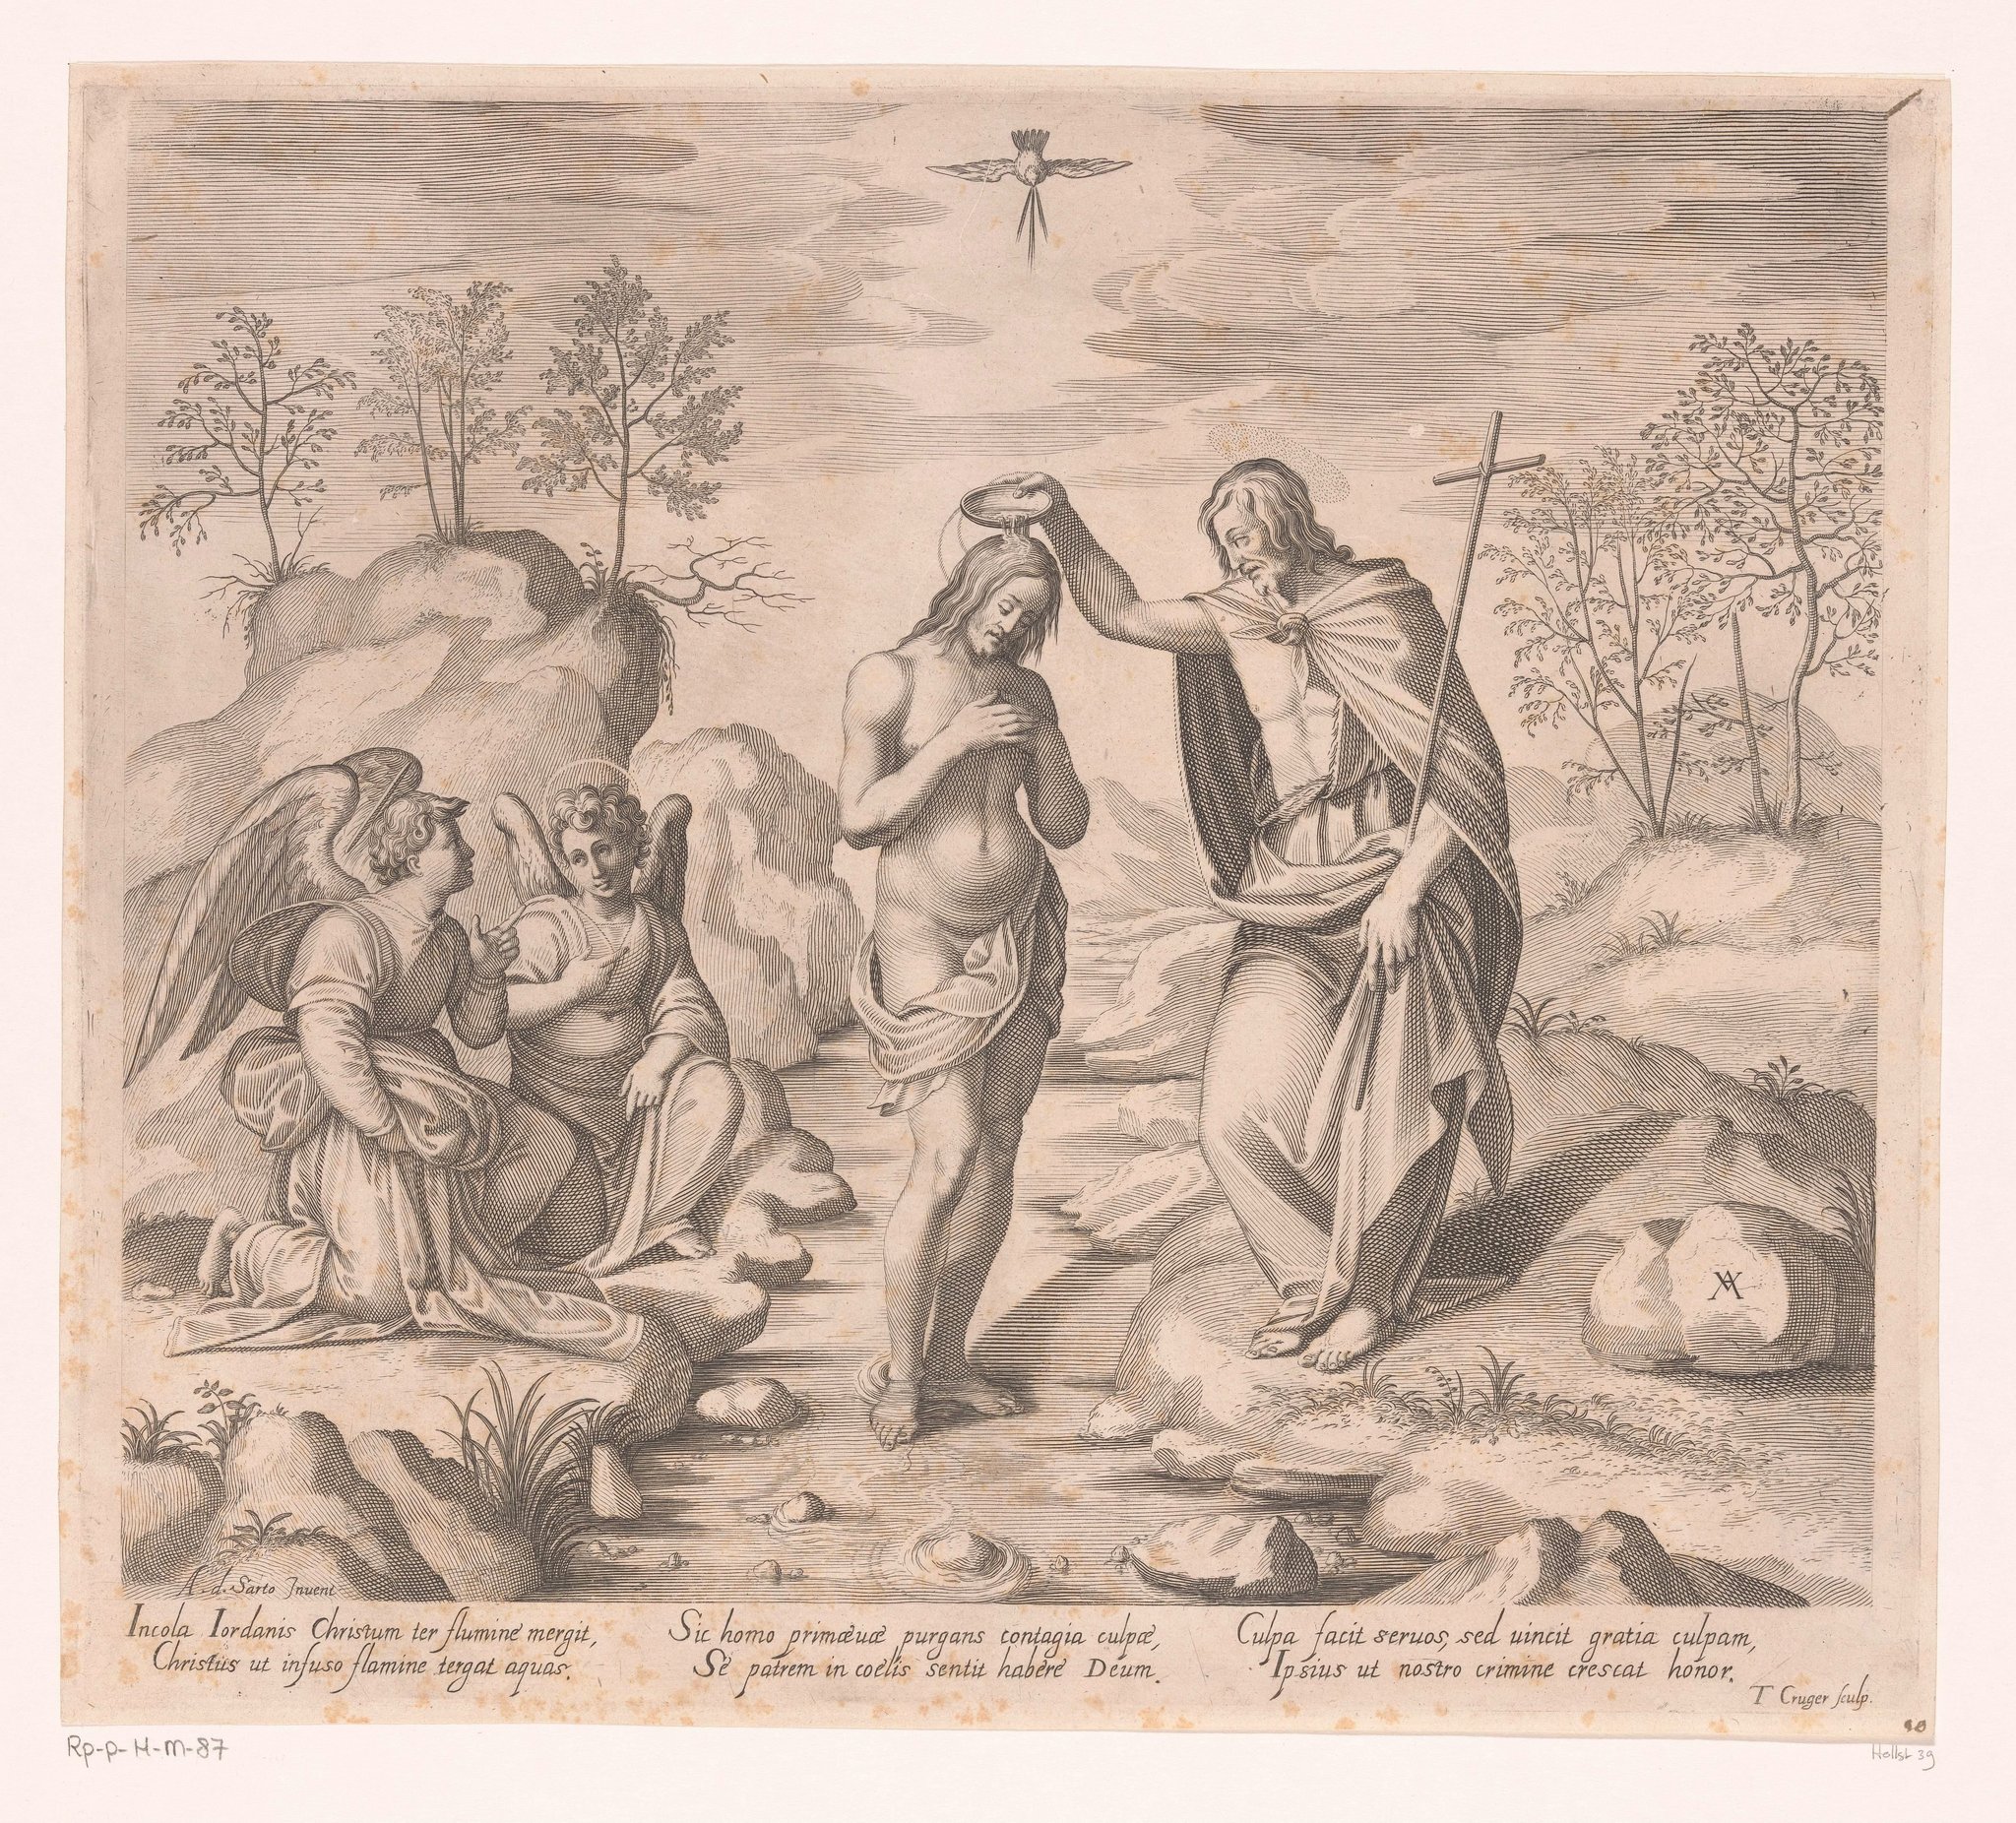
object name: print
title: Doop van Christus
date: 1617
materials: paper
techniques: engraving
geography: florence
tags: baptism of christ in the river jordan: john the baptist pouring out water on christ's head: the holy ghost descends (+ angel(s))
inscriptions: monogram: ‘AV’, collector's mark: Lugt 11, collector's mark: ‘Hinloopen’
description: Onderdeel van een serie van dertien prenten en een titelprent. Origineel onderdeel geweest van het album Schijnvoet-nummer 24.